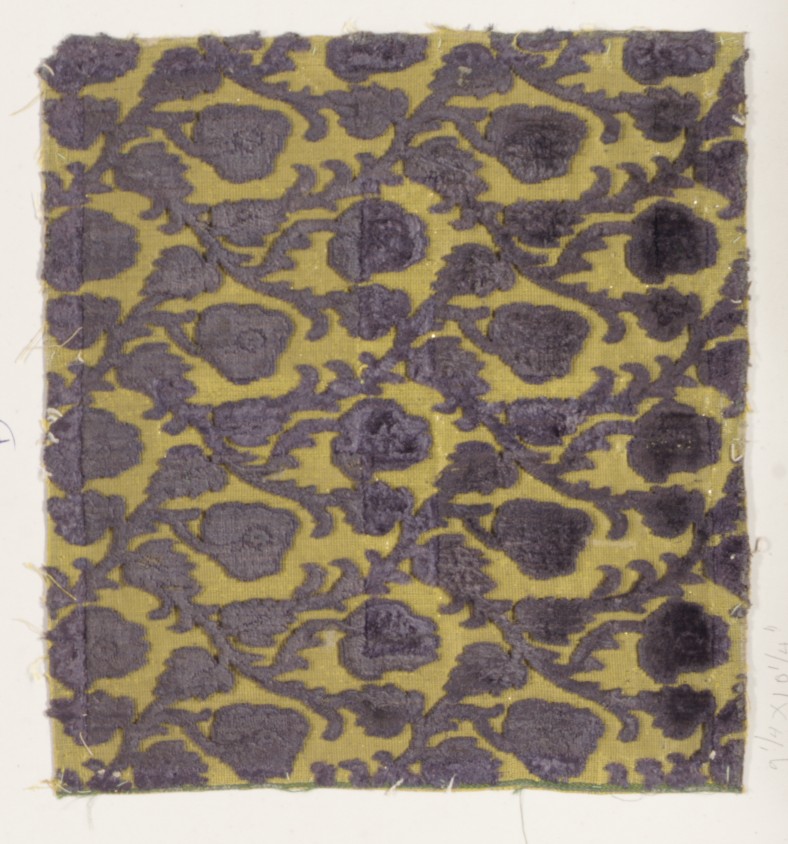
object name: fragment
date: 1567-1600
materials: metal thread, silk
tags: flowers